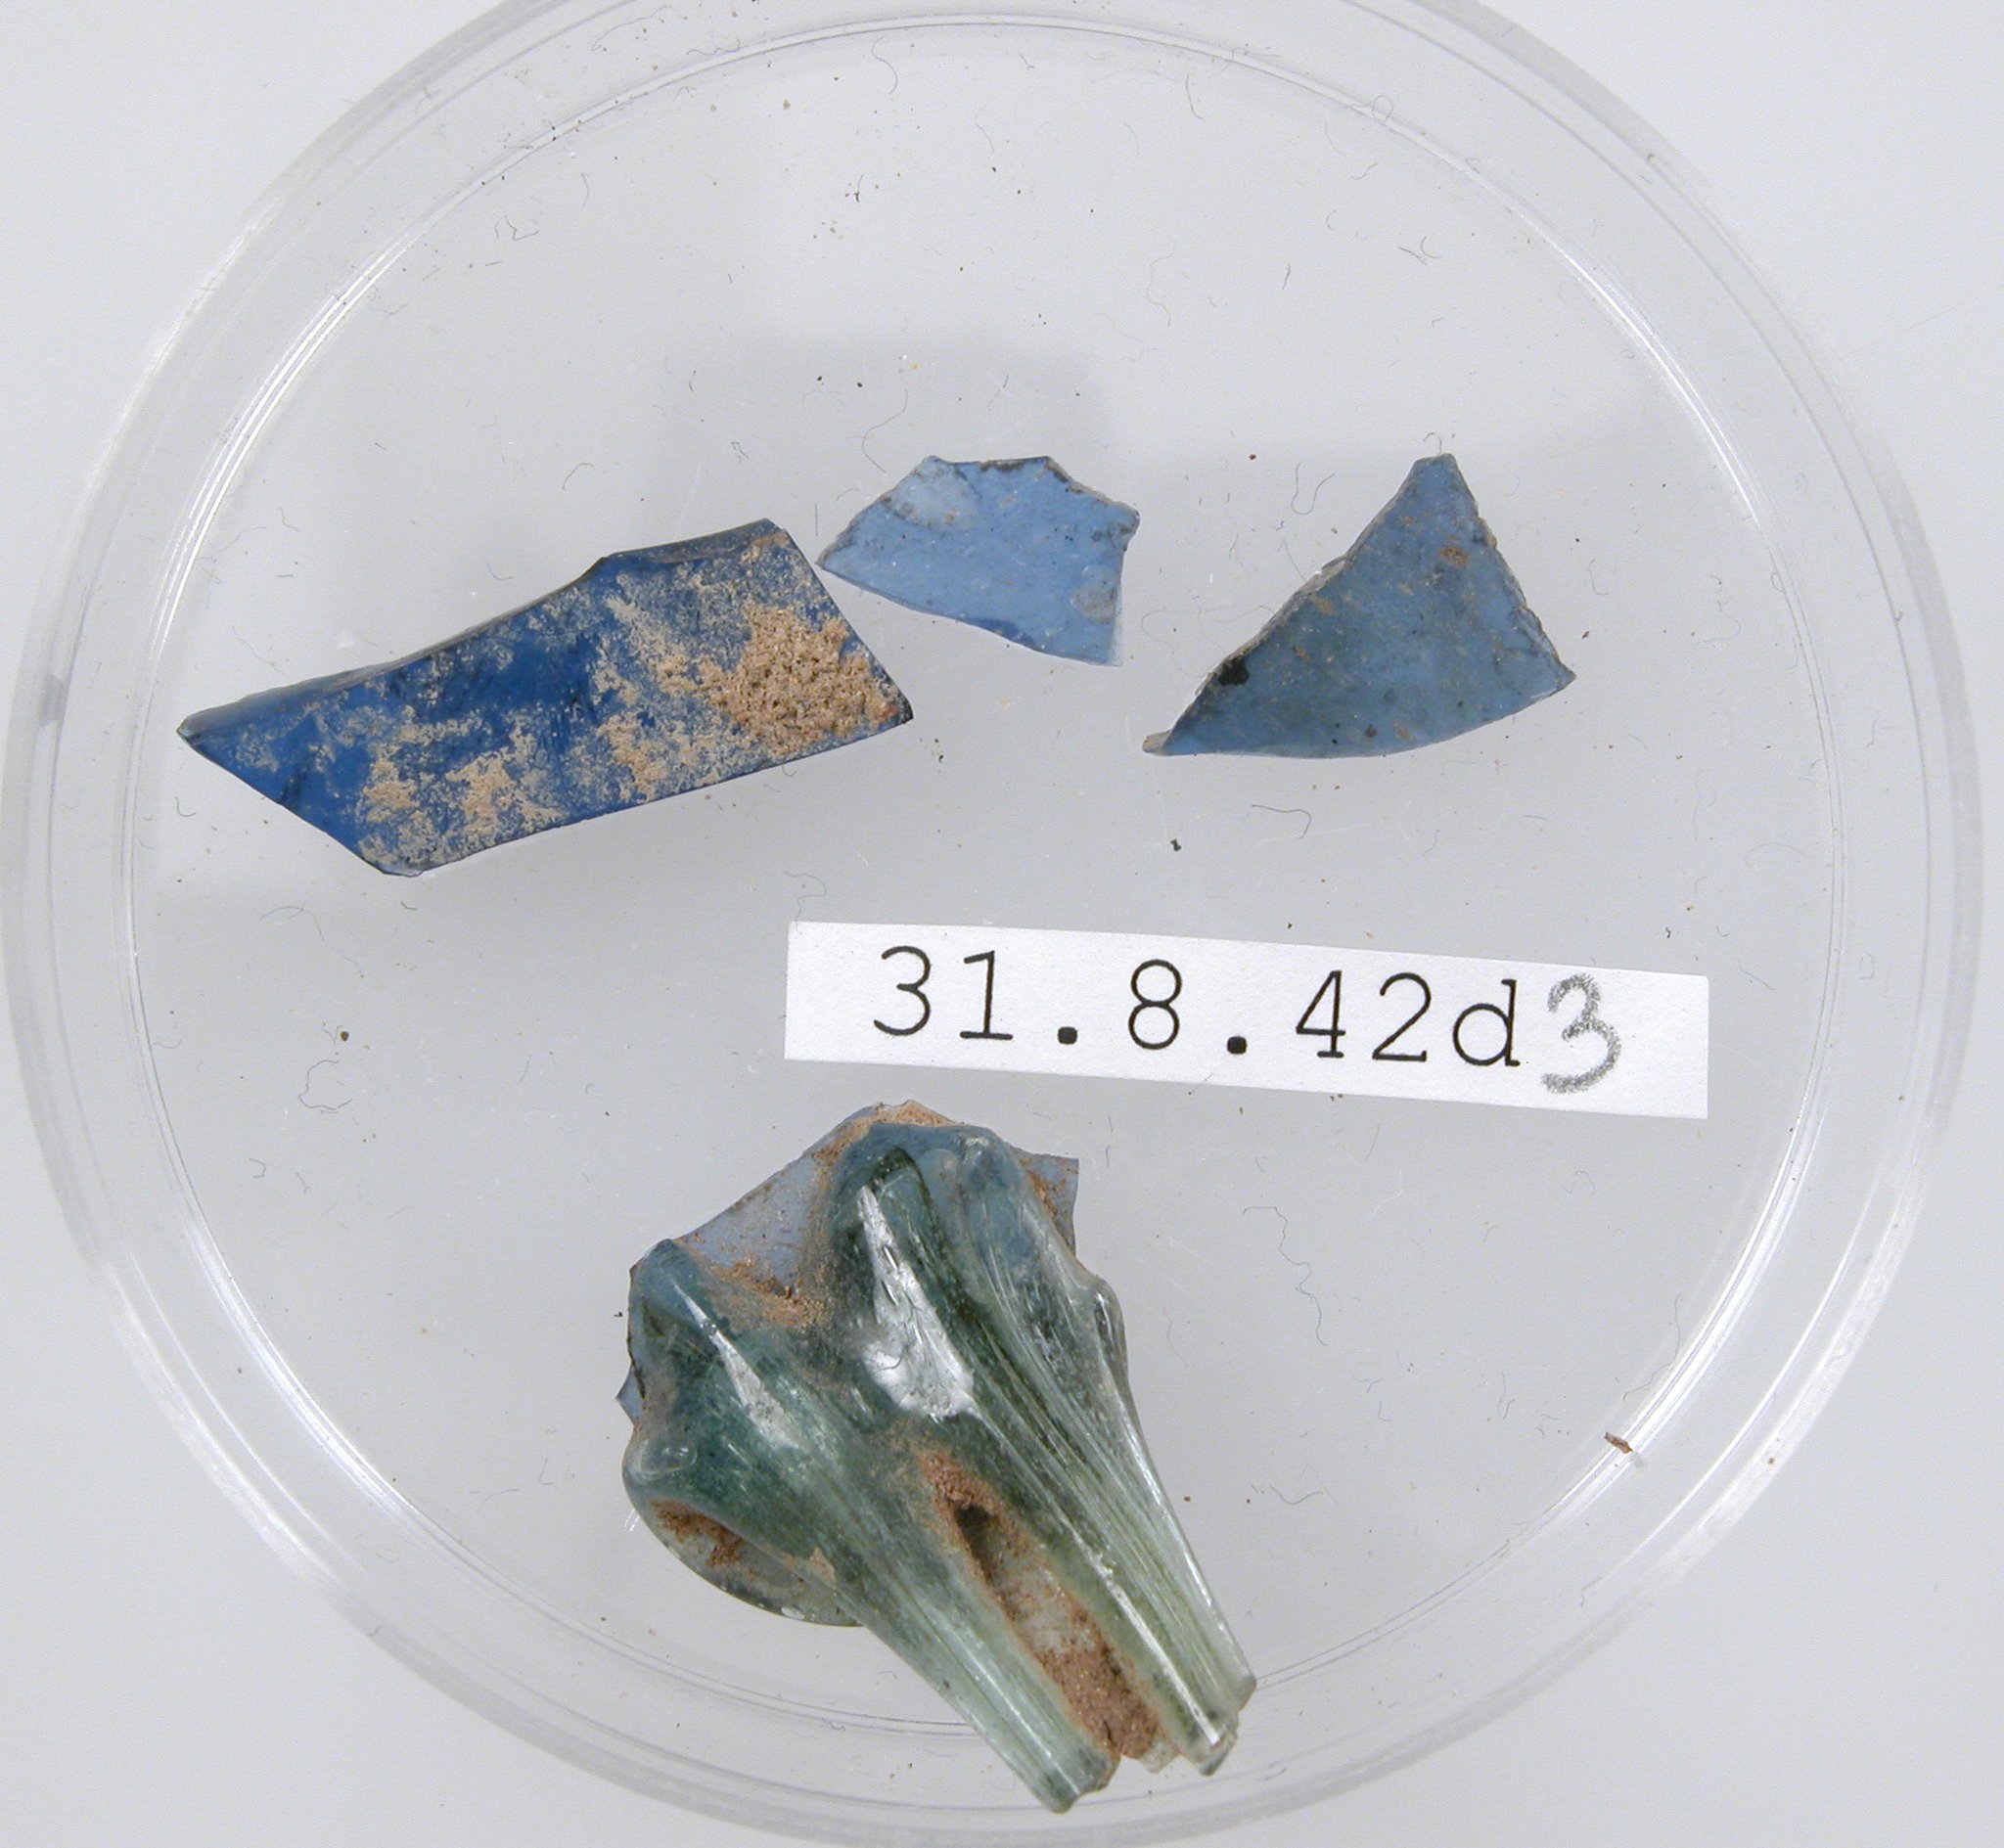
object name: fragment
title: Glass Fragments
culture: coptic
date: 301-400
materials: glass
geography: egypt